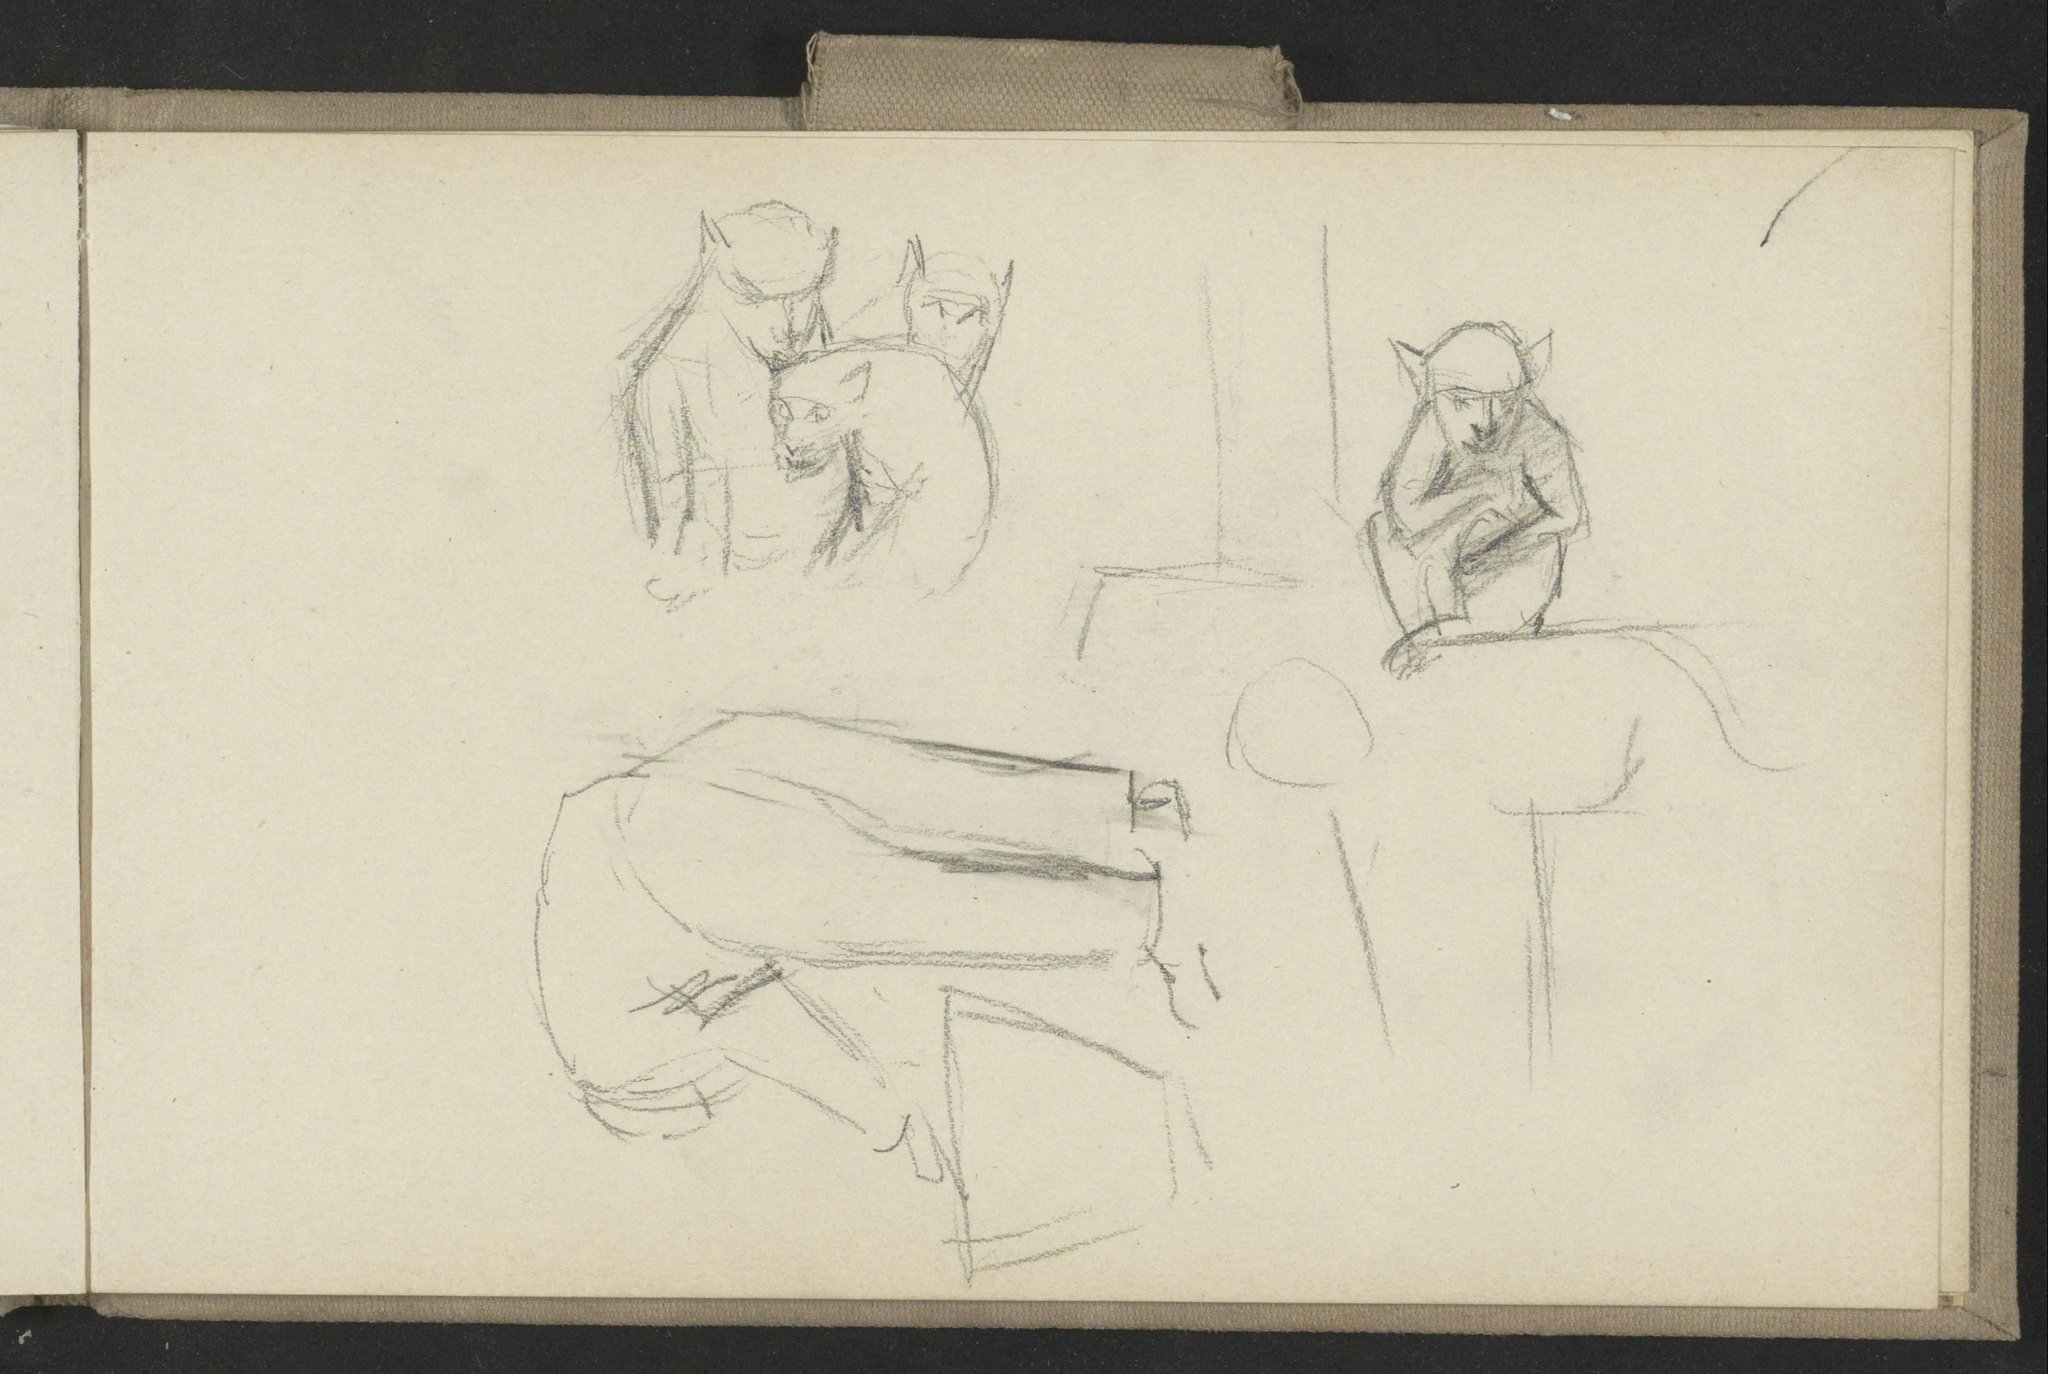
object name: sketchbook leaf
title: Bukkende man bij een bak, apen en katachtigen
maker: jozef israëls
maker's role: draughtsman, painter, print maker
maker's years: 1824-1911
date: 1834-1911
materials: paper, pencil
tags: monkeys, apes, bending figure (+ male human being (not to be used where -a- is prescribed))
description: Blad 24 recto uit een schetsboek met 26 bladen.